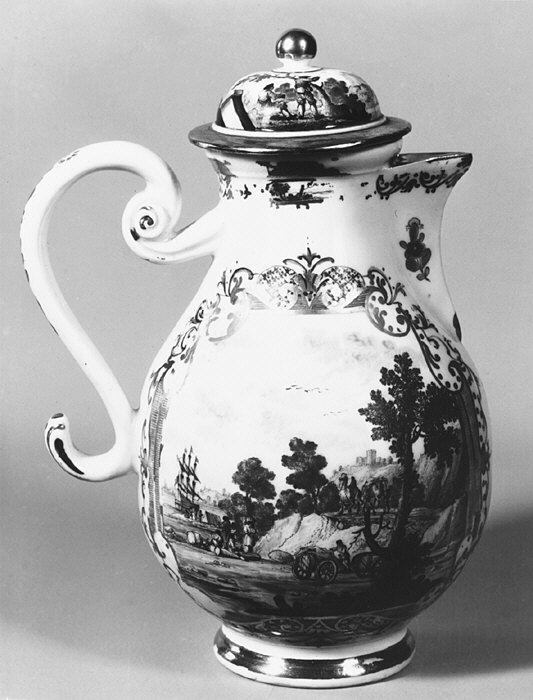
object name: coffeepot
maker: meissen manufactory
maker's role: manufactory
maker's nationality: german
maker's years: 1710-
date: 1735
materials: hard paste porcelain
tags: trees